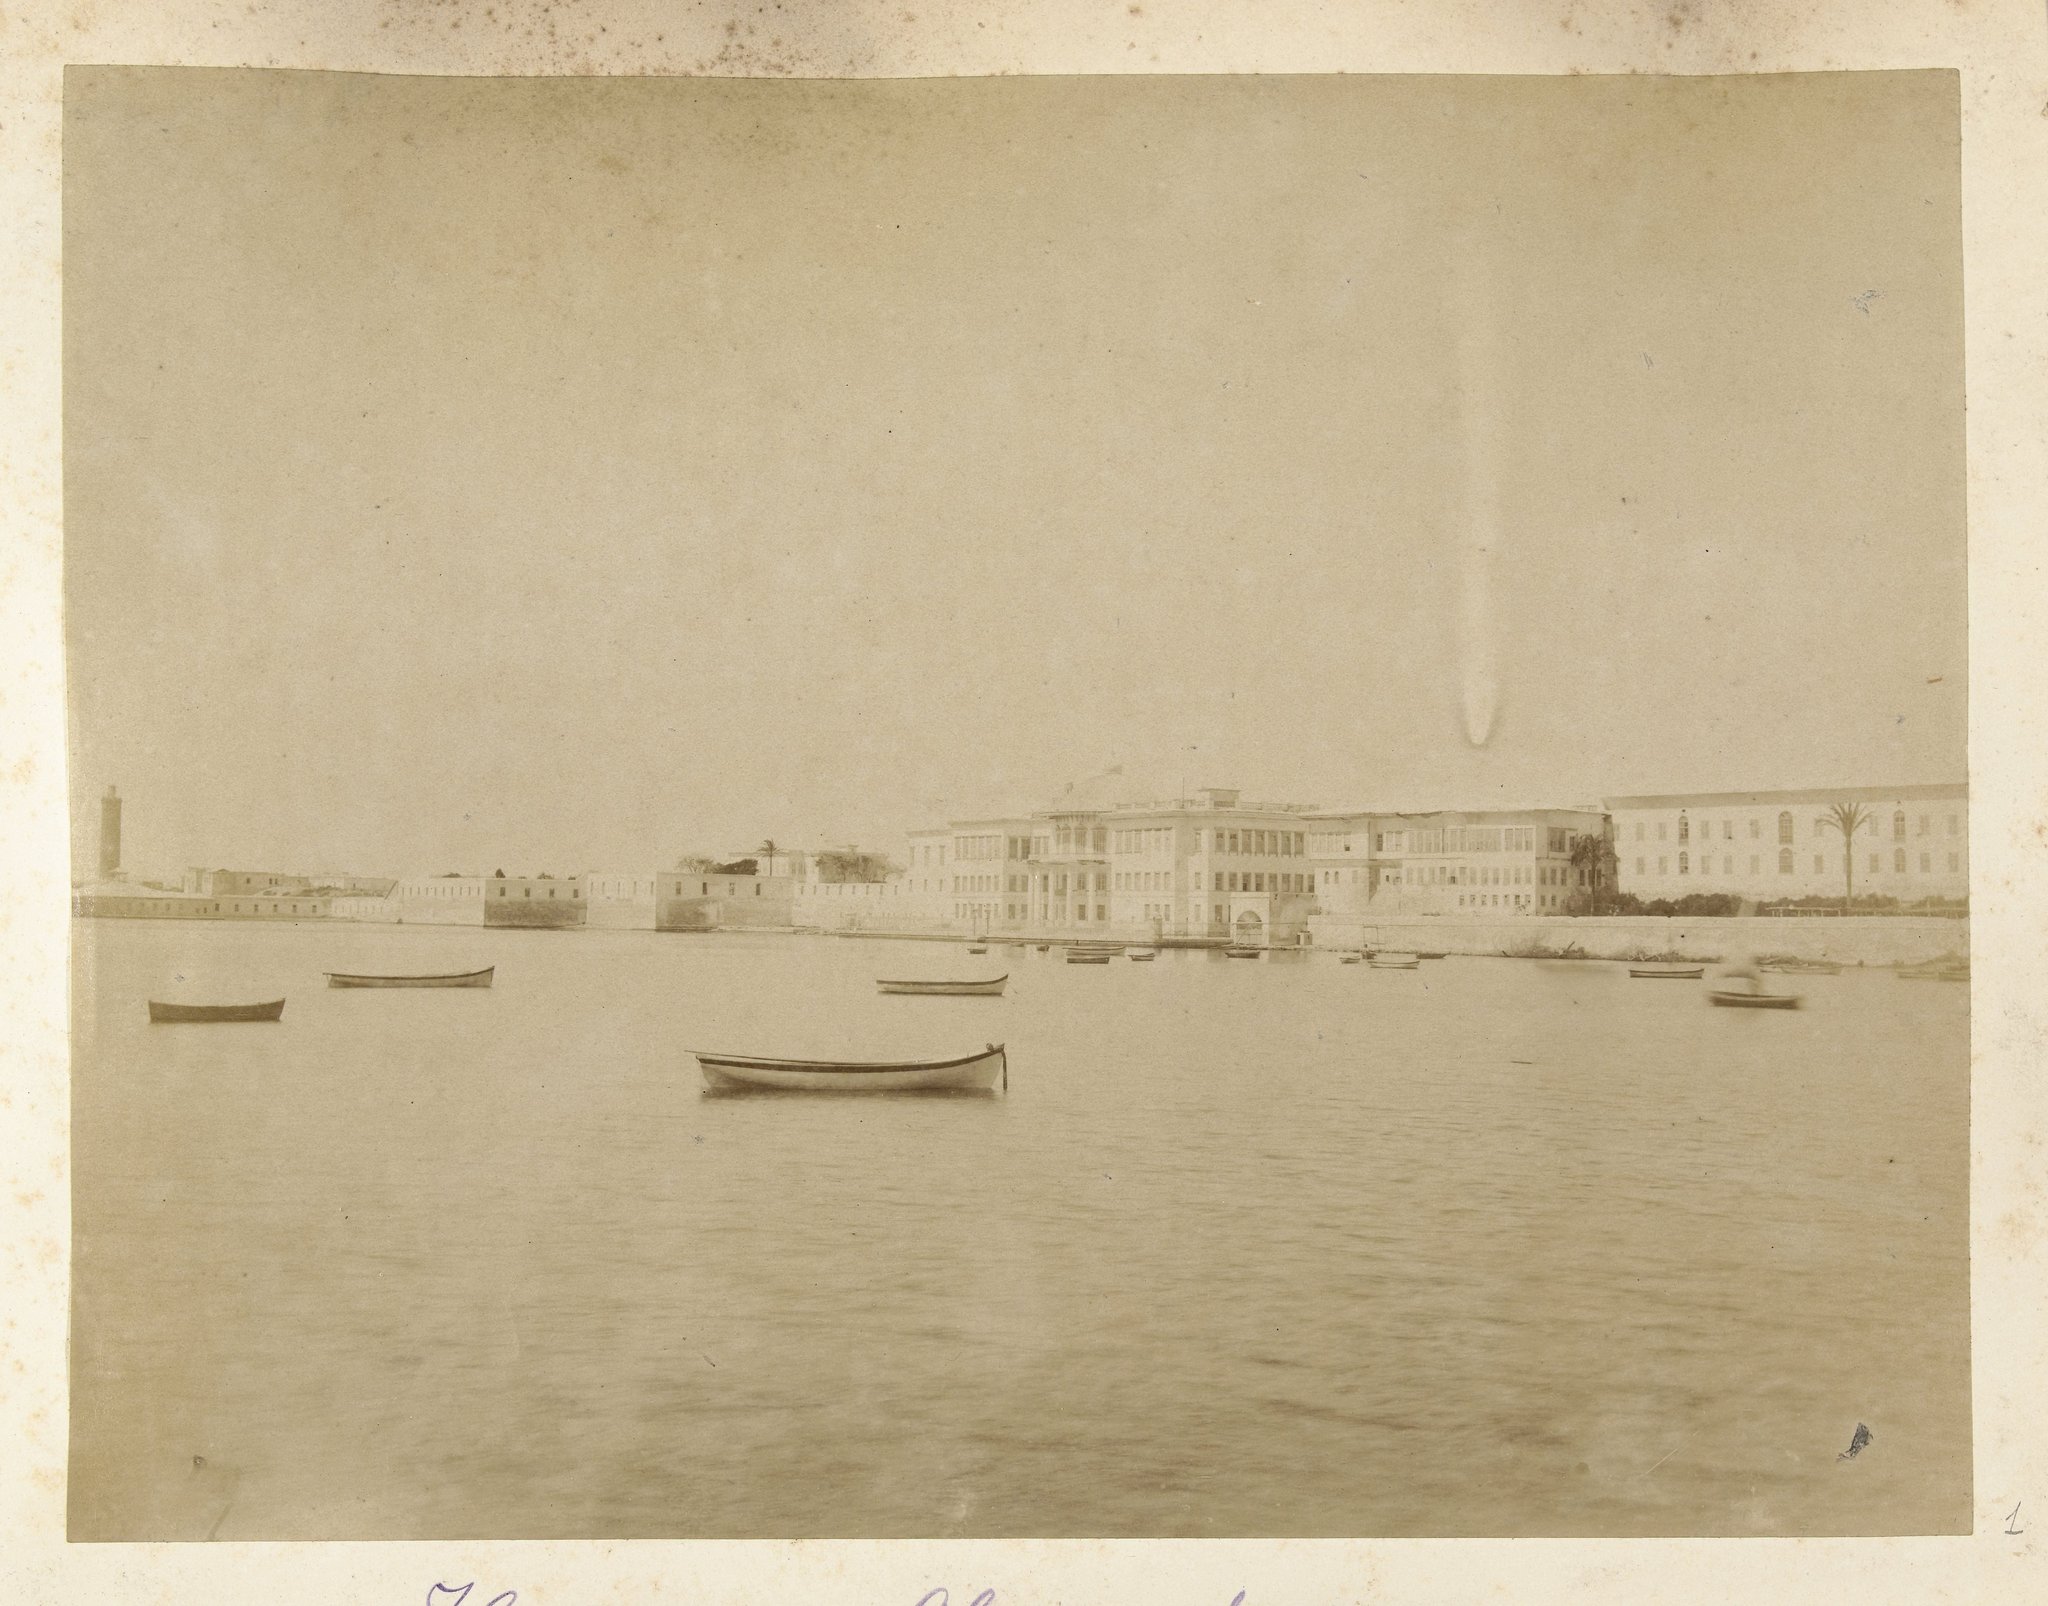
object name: photograph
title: Haven van Alexandrië met voor de kust roeiboten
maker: Anonymous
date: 1890-1910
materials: cardboard, paper, photographic support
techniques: gelatin silver print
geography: netherlands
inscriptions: caption: ‘Haven van Alexandrië Paleis en Harem van den onderkoning.’